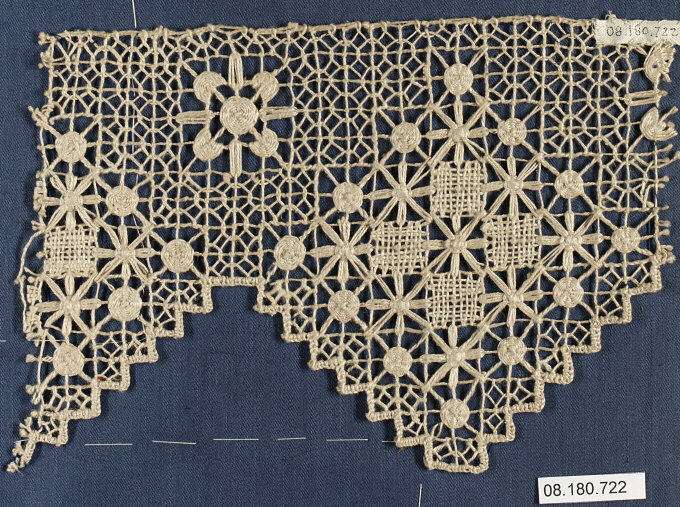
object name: fragment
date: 1801-1900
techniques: embroidery